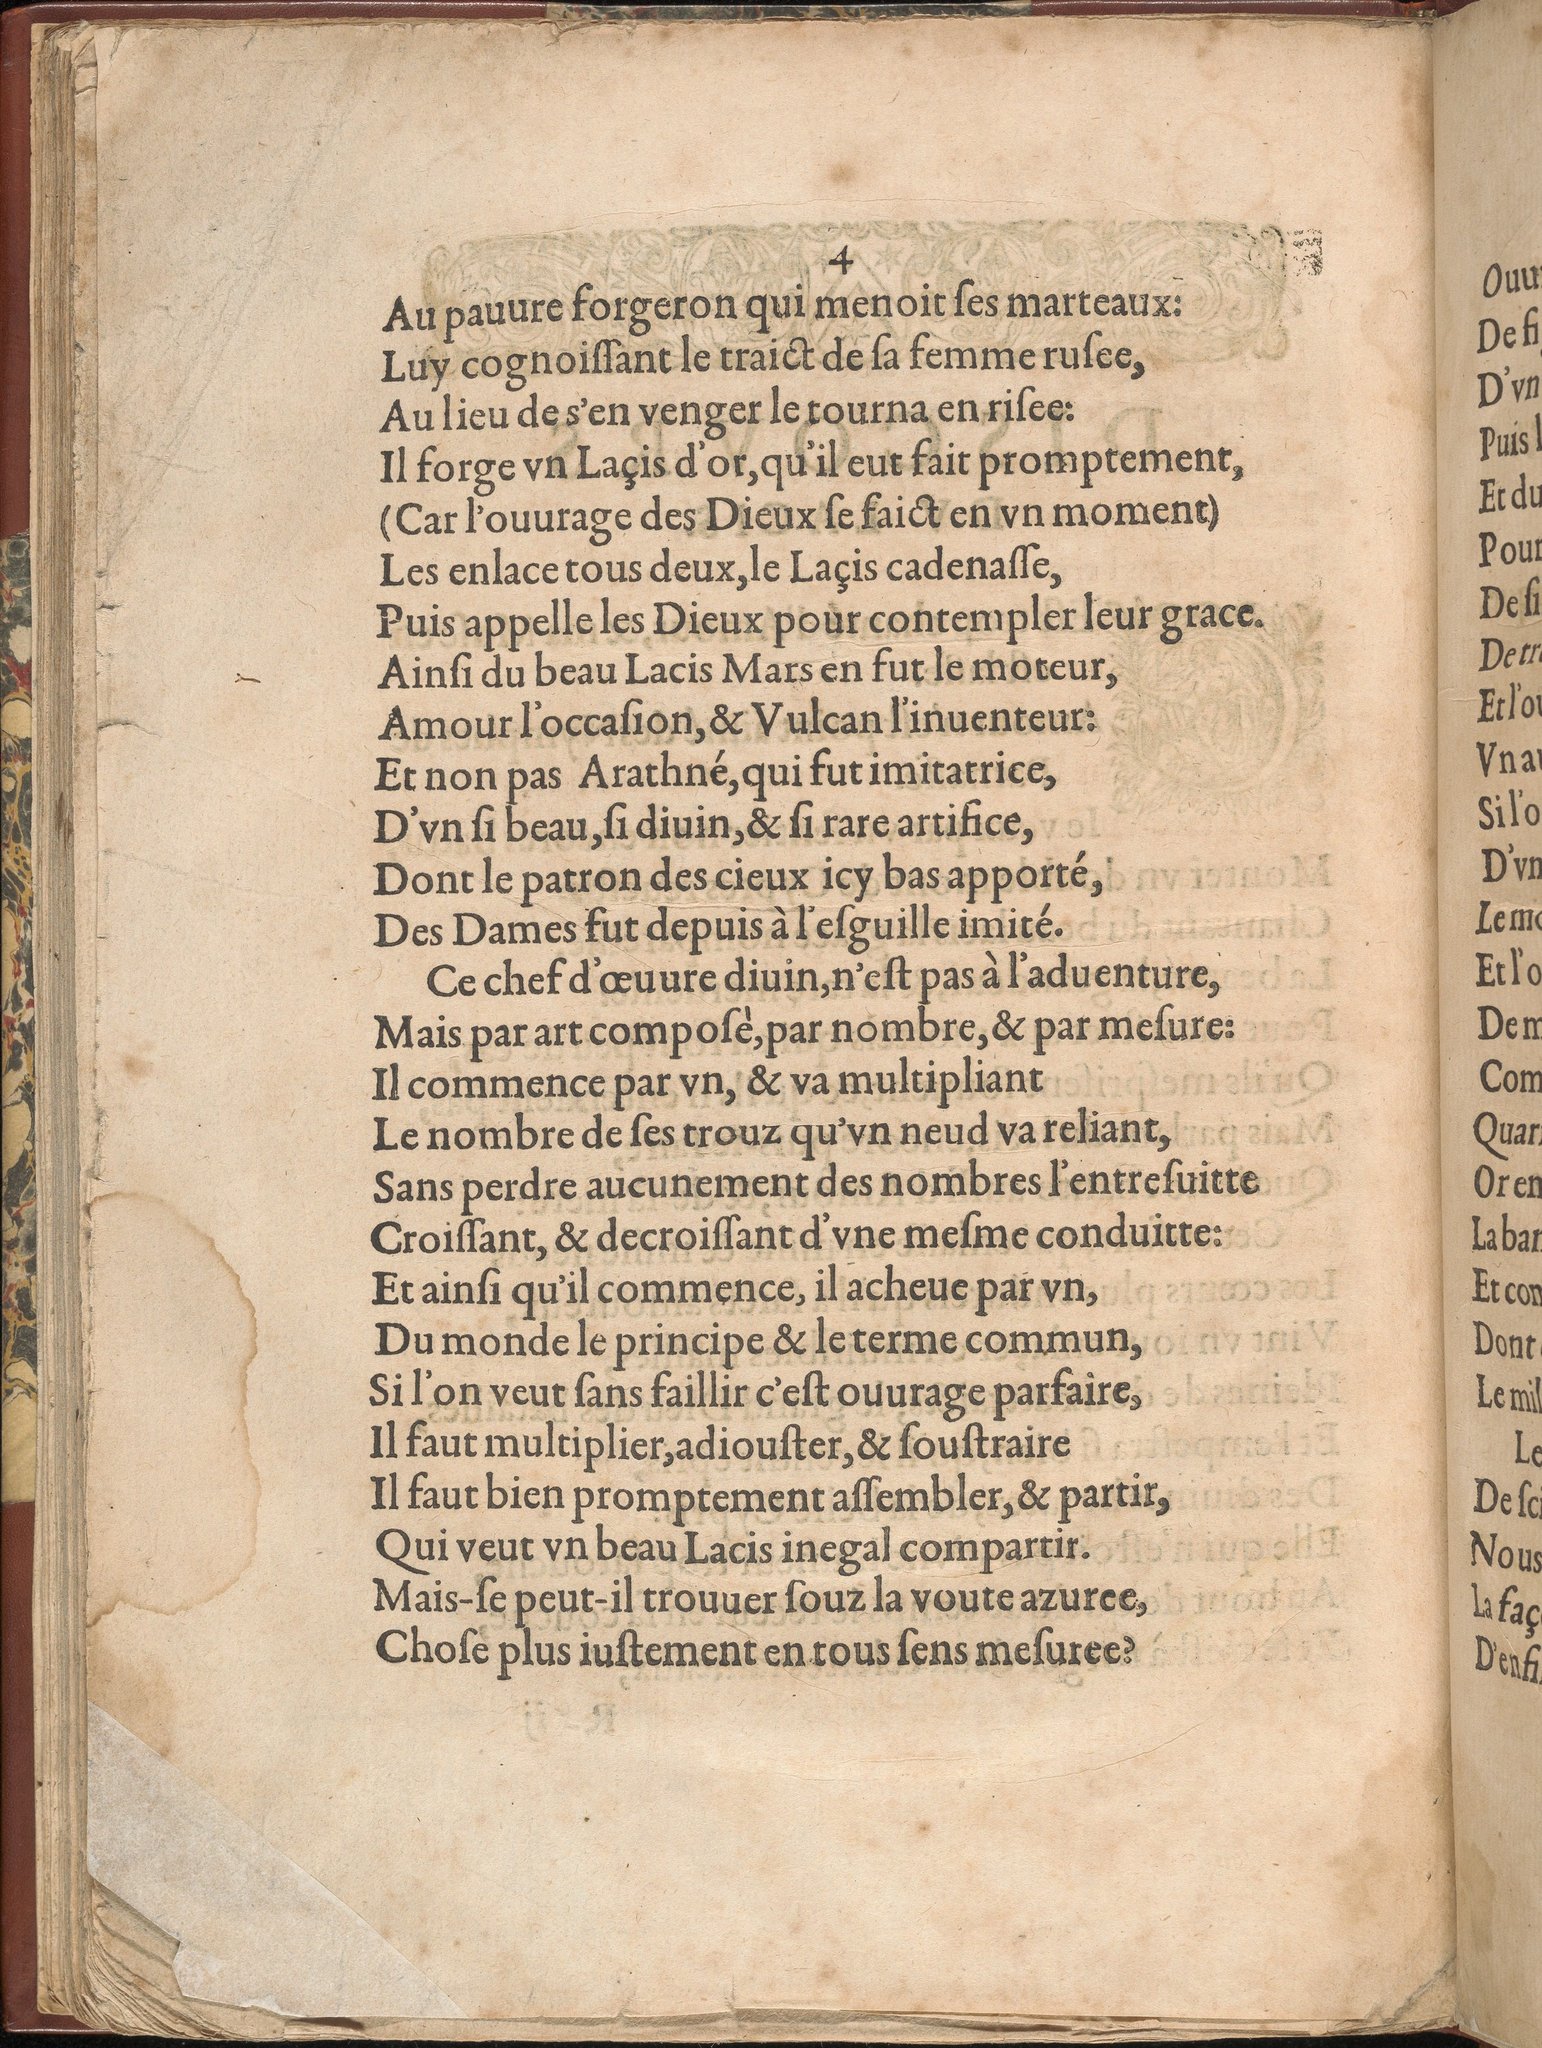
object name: book print ornament architecture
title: Les Secondes Oeuvres, et Subtiles Inventions De Lingerie du Seigneur Federic de Vinciolo Venitien, page 66 (verso)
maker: federico de vinciolo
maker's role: designer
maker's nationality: italian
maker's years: 1582-1599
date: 1603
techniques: woodcut